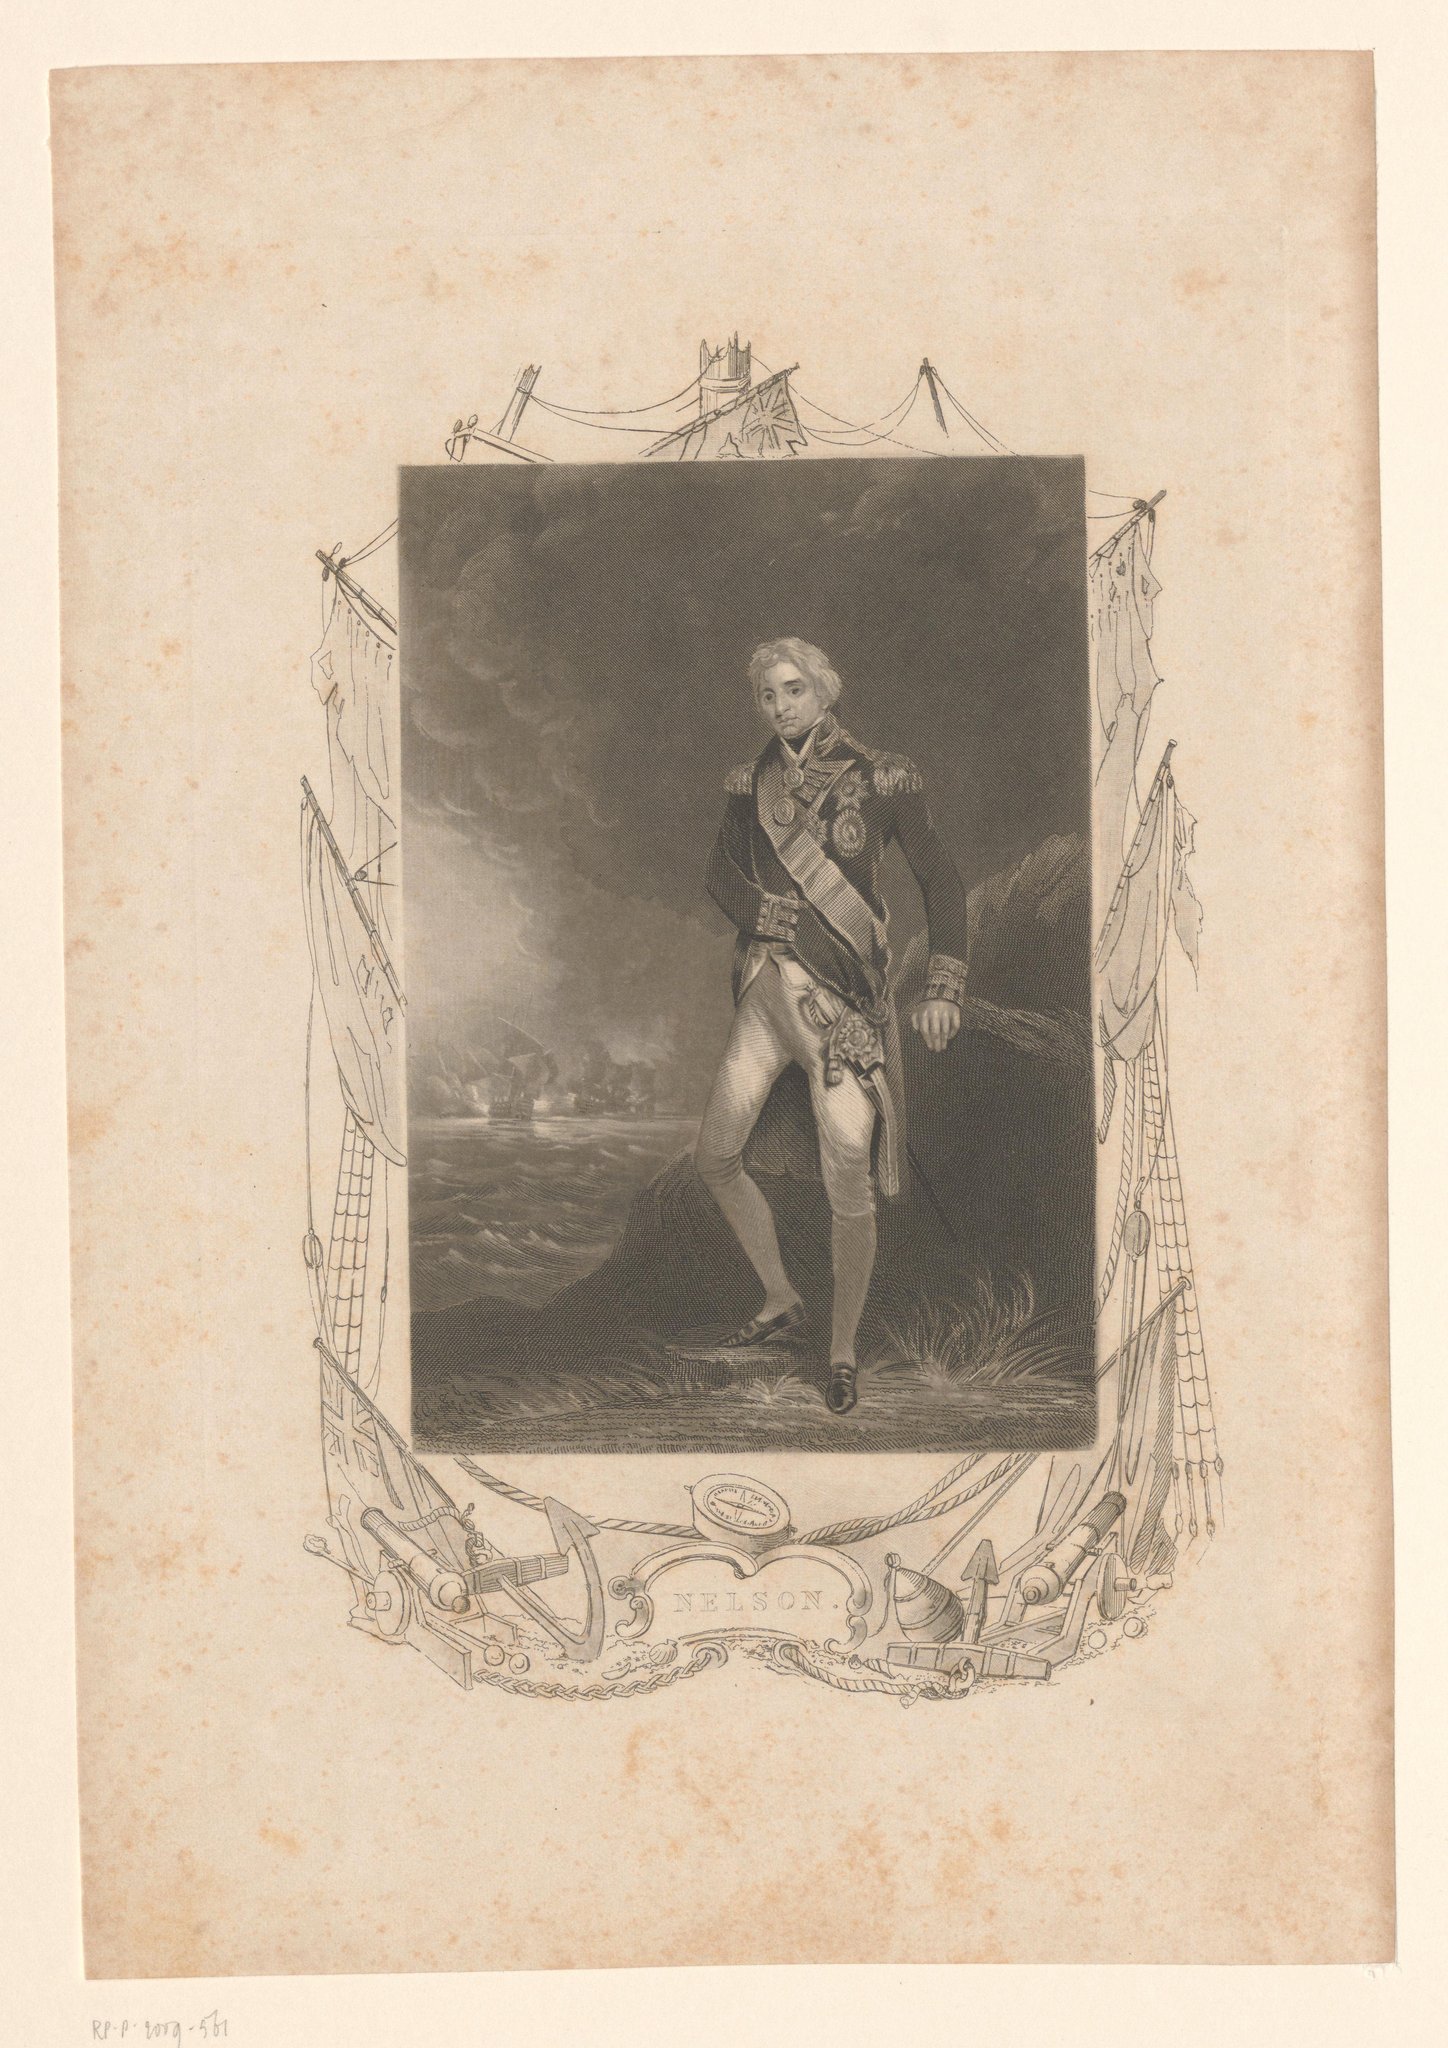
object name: print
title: Portret van Horatio Nelson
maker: Anonymous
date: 1797-1849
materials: paper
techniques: etching, roulette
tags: horatio nelson (hertog van bronte), historical persons, commander-in-chief, admiral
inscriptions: collector's mark: Lugt 2228, stamp: ‘M./ v.S.’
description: Portret van Horatio Nelson in ovaal in uniform met medailles en sjerp naar links. Op zijn linkeroog draagt hij een zwart lapje. Onder ovaal staat zijn naam.